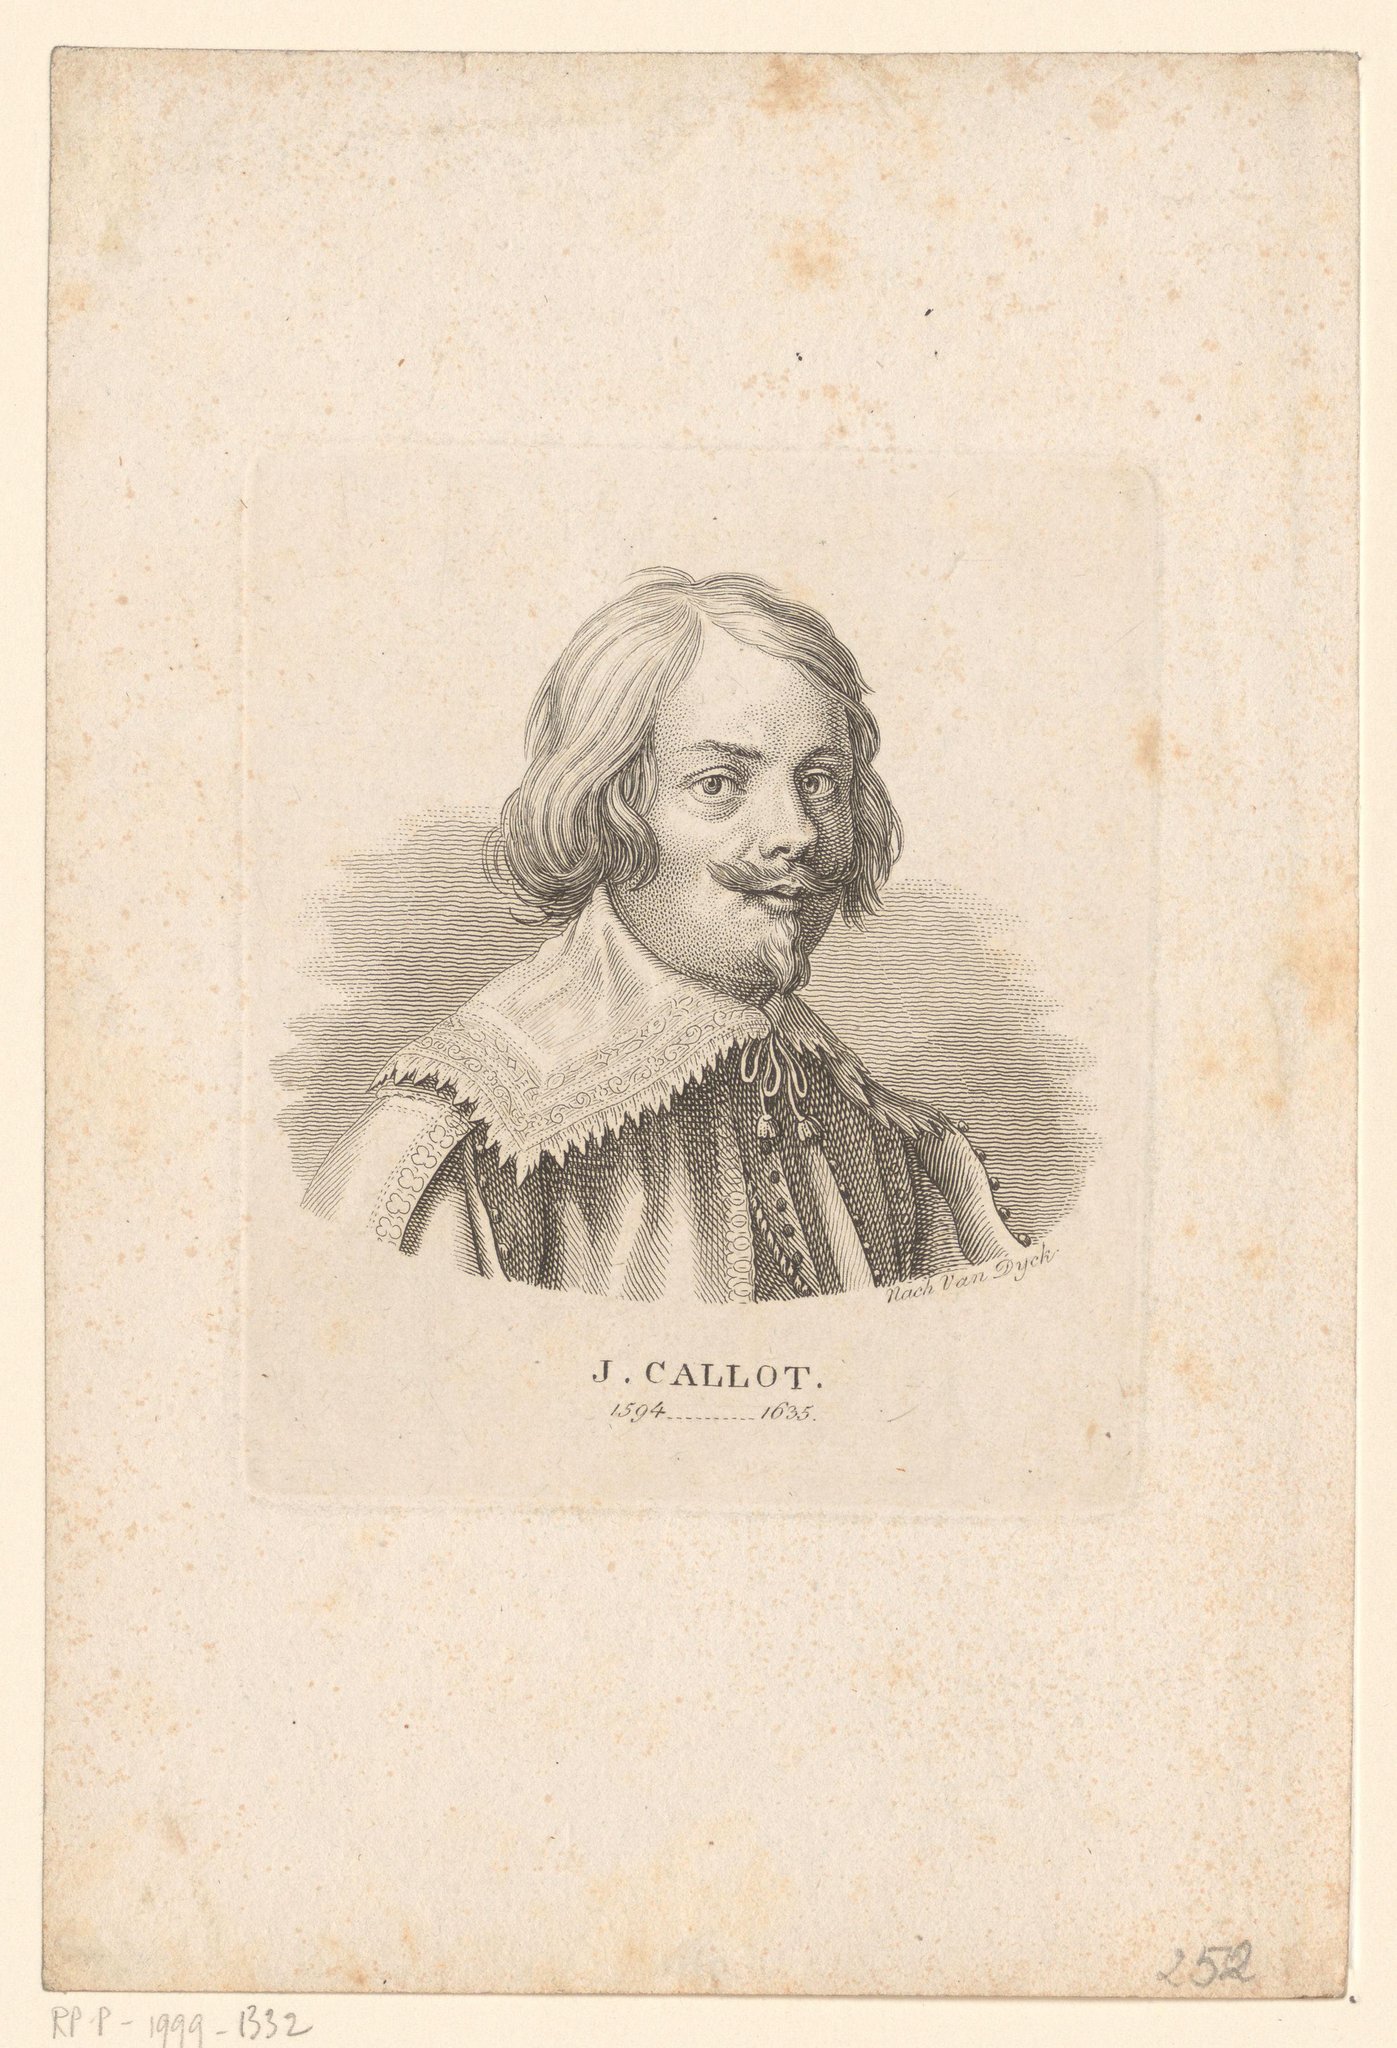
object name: print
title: Portret van Jacques Callot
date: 1700-1799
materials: paper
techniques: etching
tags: print maker, draughtsman, jacques callot, historical persons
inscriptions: collector's mark: Lugt 2228, collector's mark: Lugt 2760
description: Buste naar rechts. Tegenzijdige kopie van prent Lucas Vorsterman I, waar Callot ten halve lijve is afgebeeld achter zijn werktafel, naar schilderij van Van Dijck.